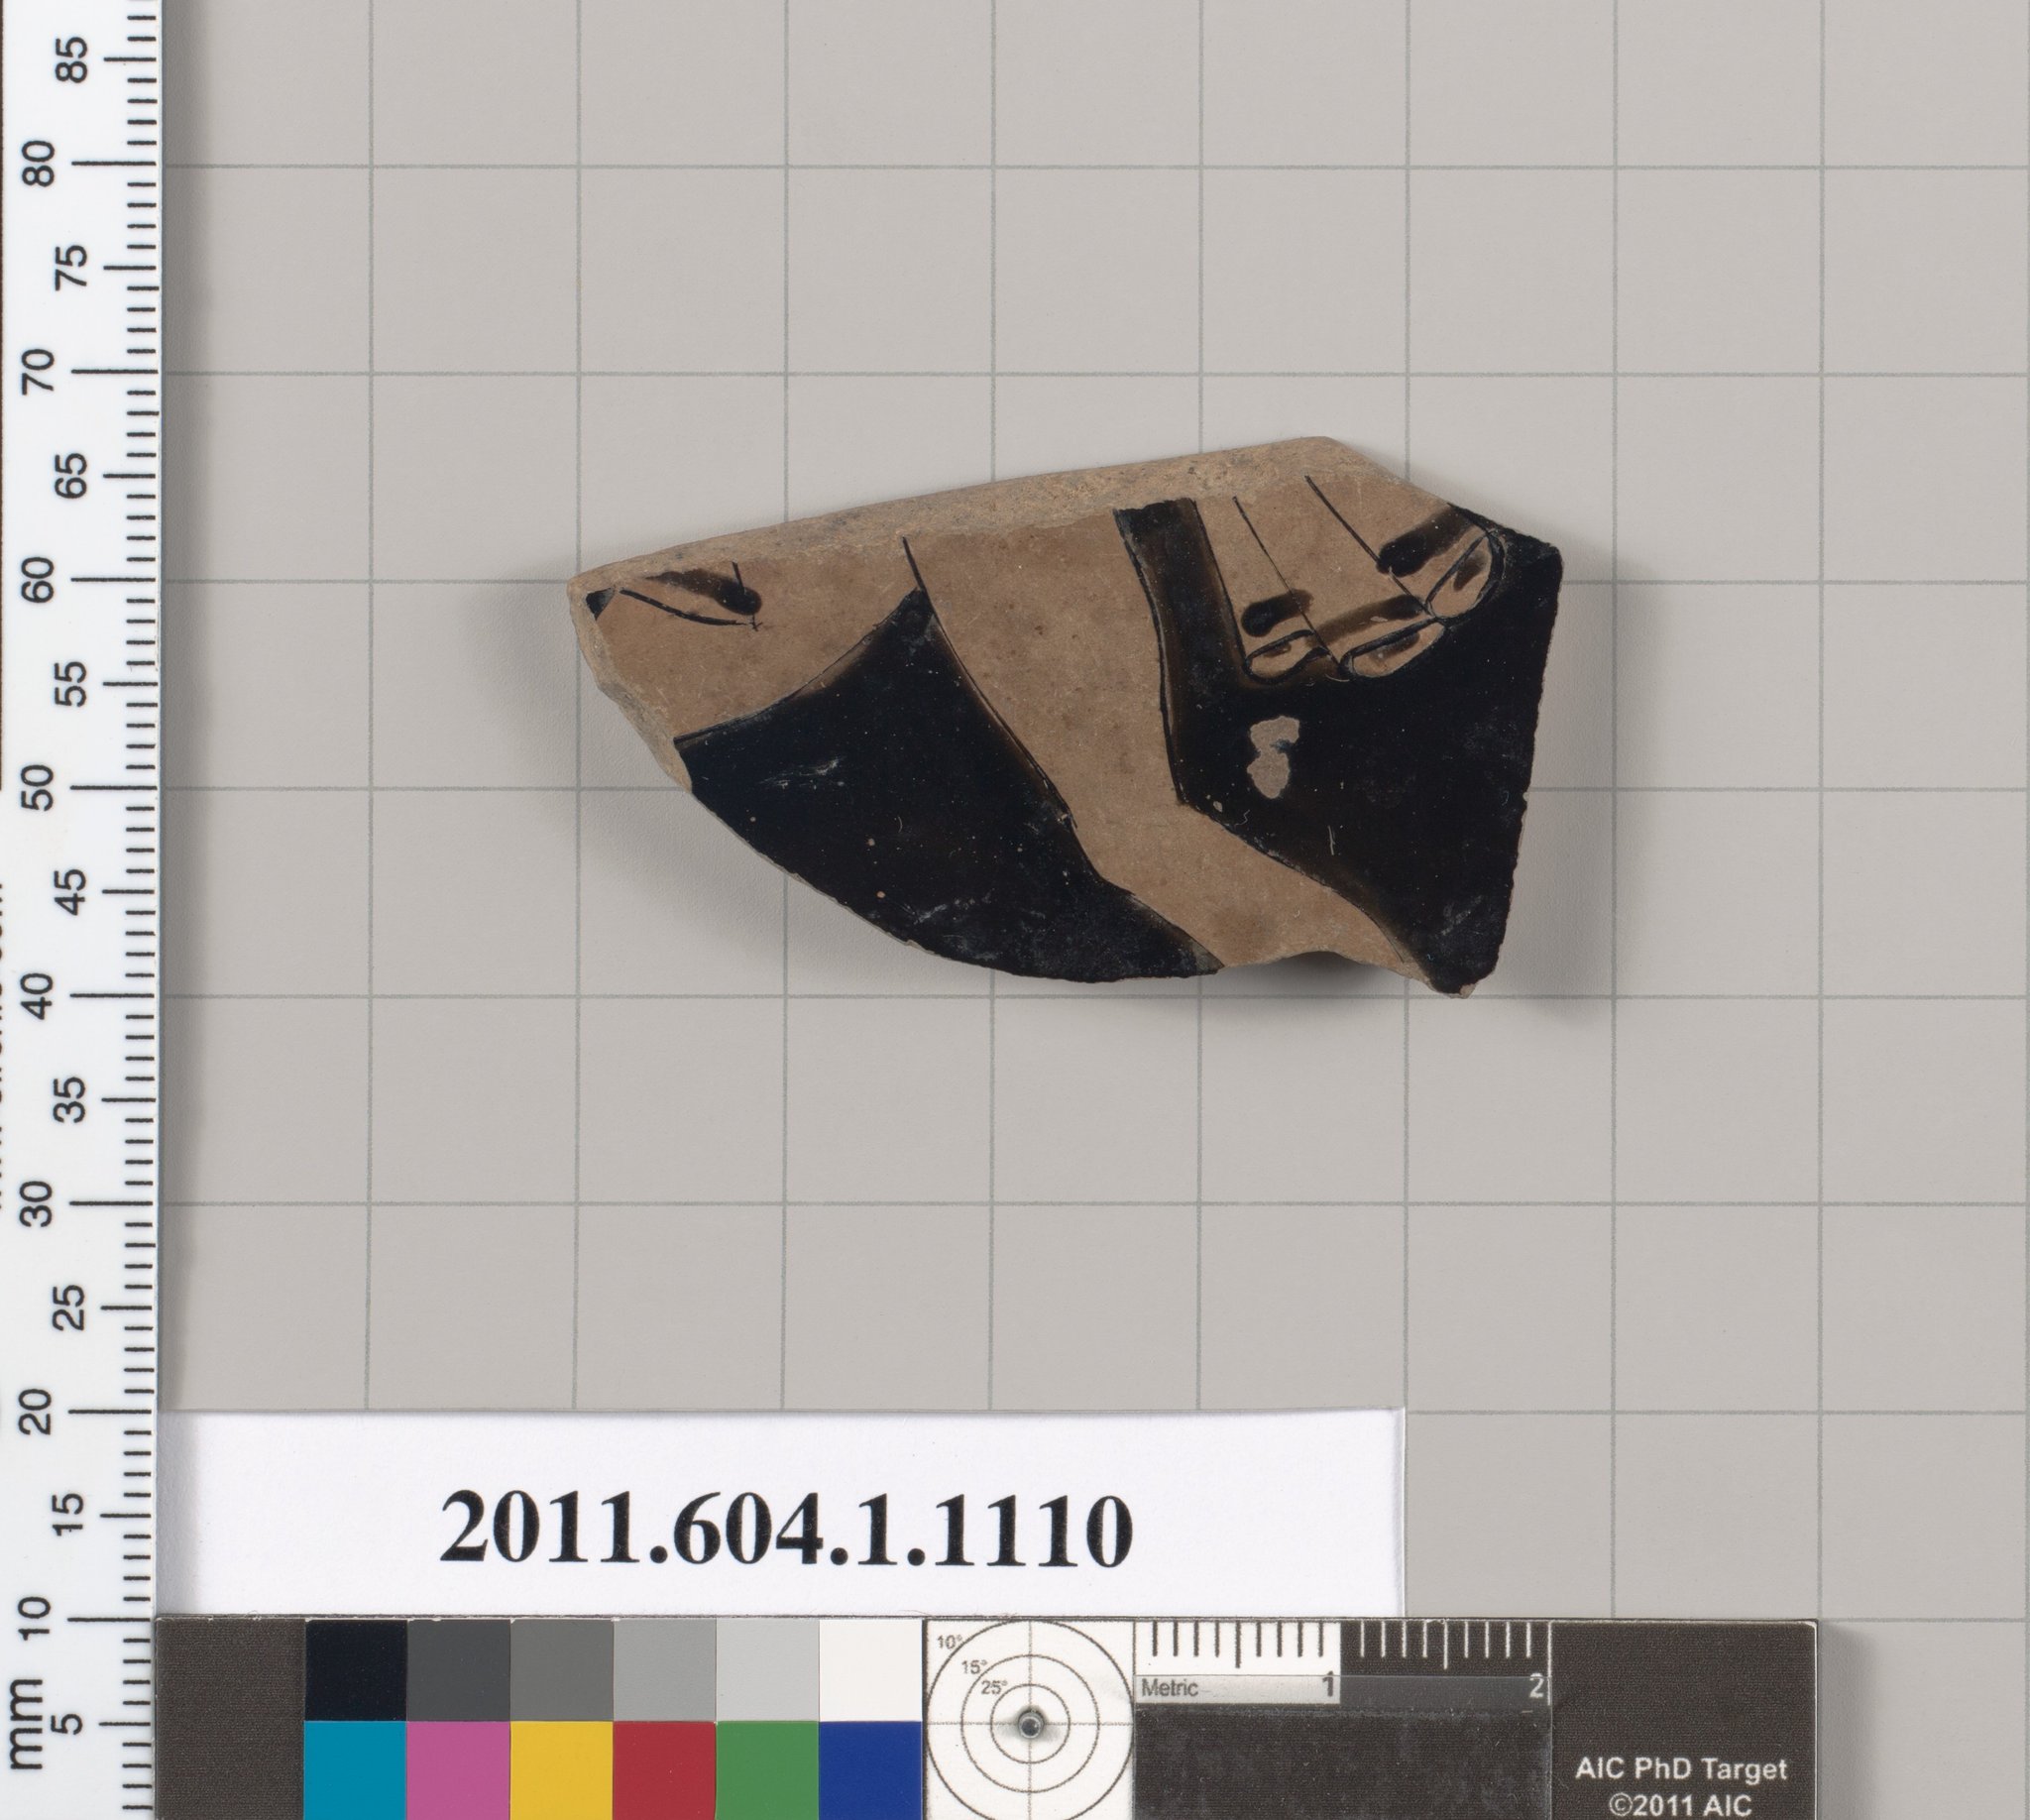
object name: kylix fragment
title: Terracotta fragment of a kylix (drinking cup)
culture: greek, attic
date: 490-480 BCE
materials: terracotta